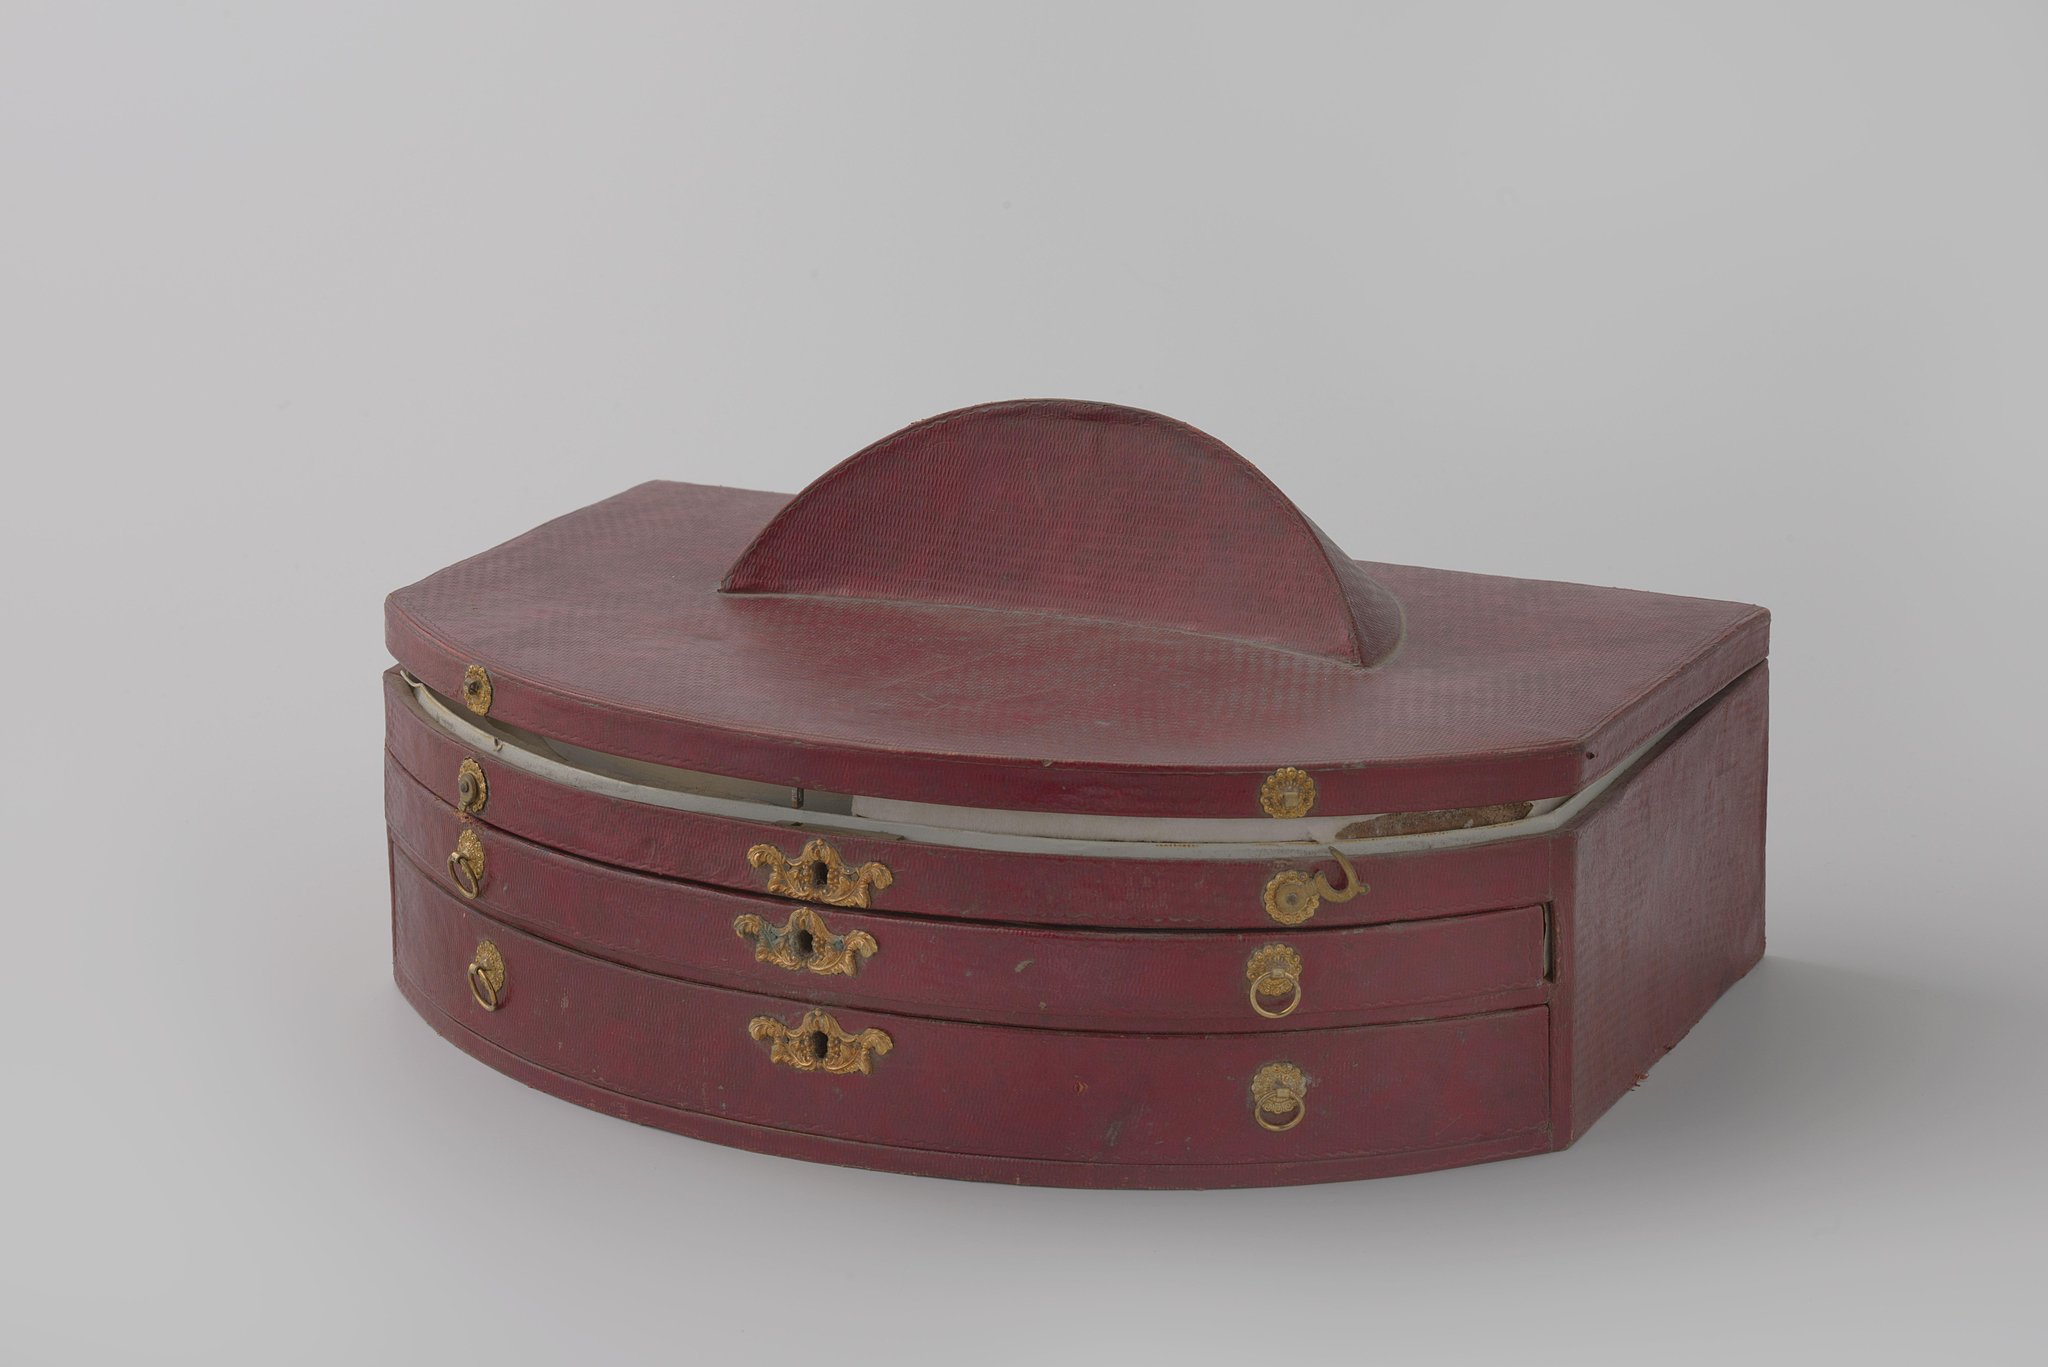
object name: verpakking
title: Parure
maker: jean baptiste bonnard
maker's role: goldsmith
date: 1824-1829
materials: gemstone, gold, leather, textile, wood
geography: amsterdam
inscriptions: alloy mark: ‘leeuwenkop naar links (Nederland, 1813-1906)’, maker's mark: ‘BB met ster in ellips’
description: Foedraal voor parure bestaande uit een collier, twee armbanden, een stel oorhangers, twee spelden en een broche. Twee laden en een deksel met uitsparing. Voorkant foedraal halfrond met drie sloten en twee grendeltjes.